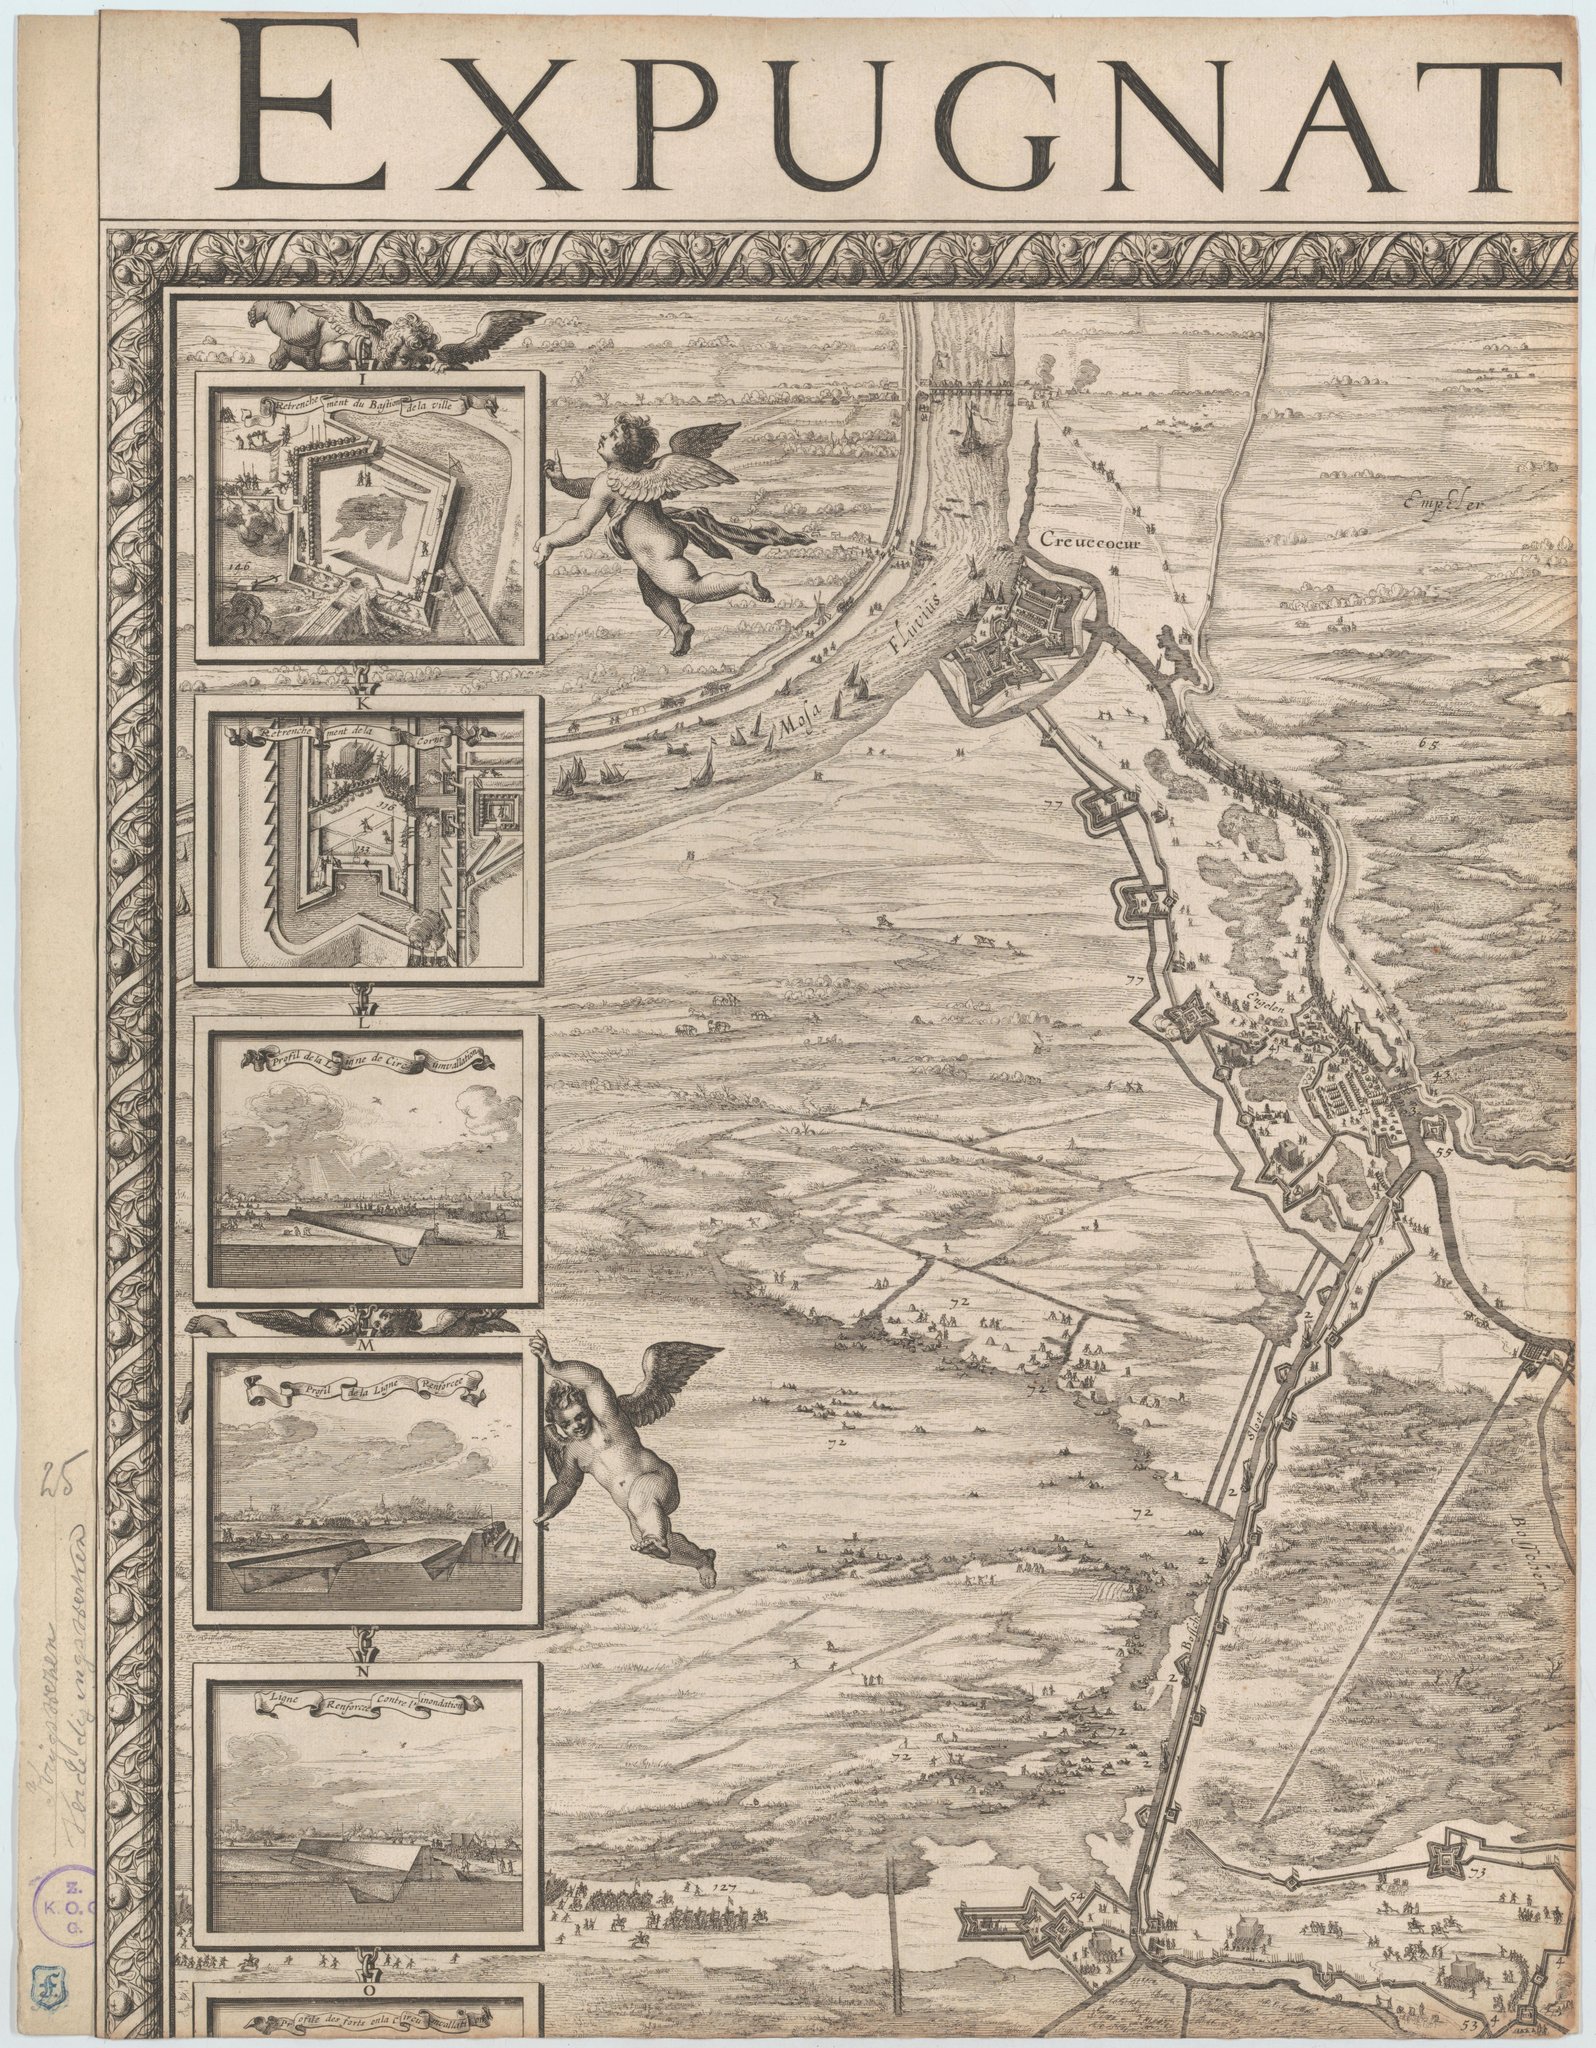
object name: print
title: Expugnatio Sylvae-Ducis Ao 1629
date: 1629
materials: paper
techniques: etching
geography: the hague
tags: delft, the hague, frederick henry (prince of orange), maps of separate countries or regions, siege, position war, den bosch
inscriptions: collector's mark: Lugt 1641, stamp, collector's mark: Lugt 963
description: Grote kaart van het beleg van Den Bosch door het Staatse leger onder Frederik Hendrik, van 1 mei tot 17 september 1629. Aan weerszijden van de kaart 18 kleine voorstellingen met details van de versterkingen van de stad en omliggende forten gemerkt I-Z. Kaart samengesteld uit zes platen en twee - ontbrekende - tekstbladen. Dit is het blad linksboven met een deel van de kaart met Crevecoeur en een deel van de omsingeling. Onderwerpsrubrieken binnen de Atlas Zeden en Gewoonten: Krijgswezen, Verdedigingswerken.